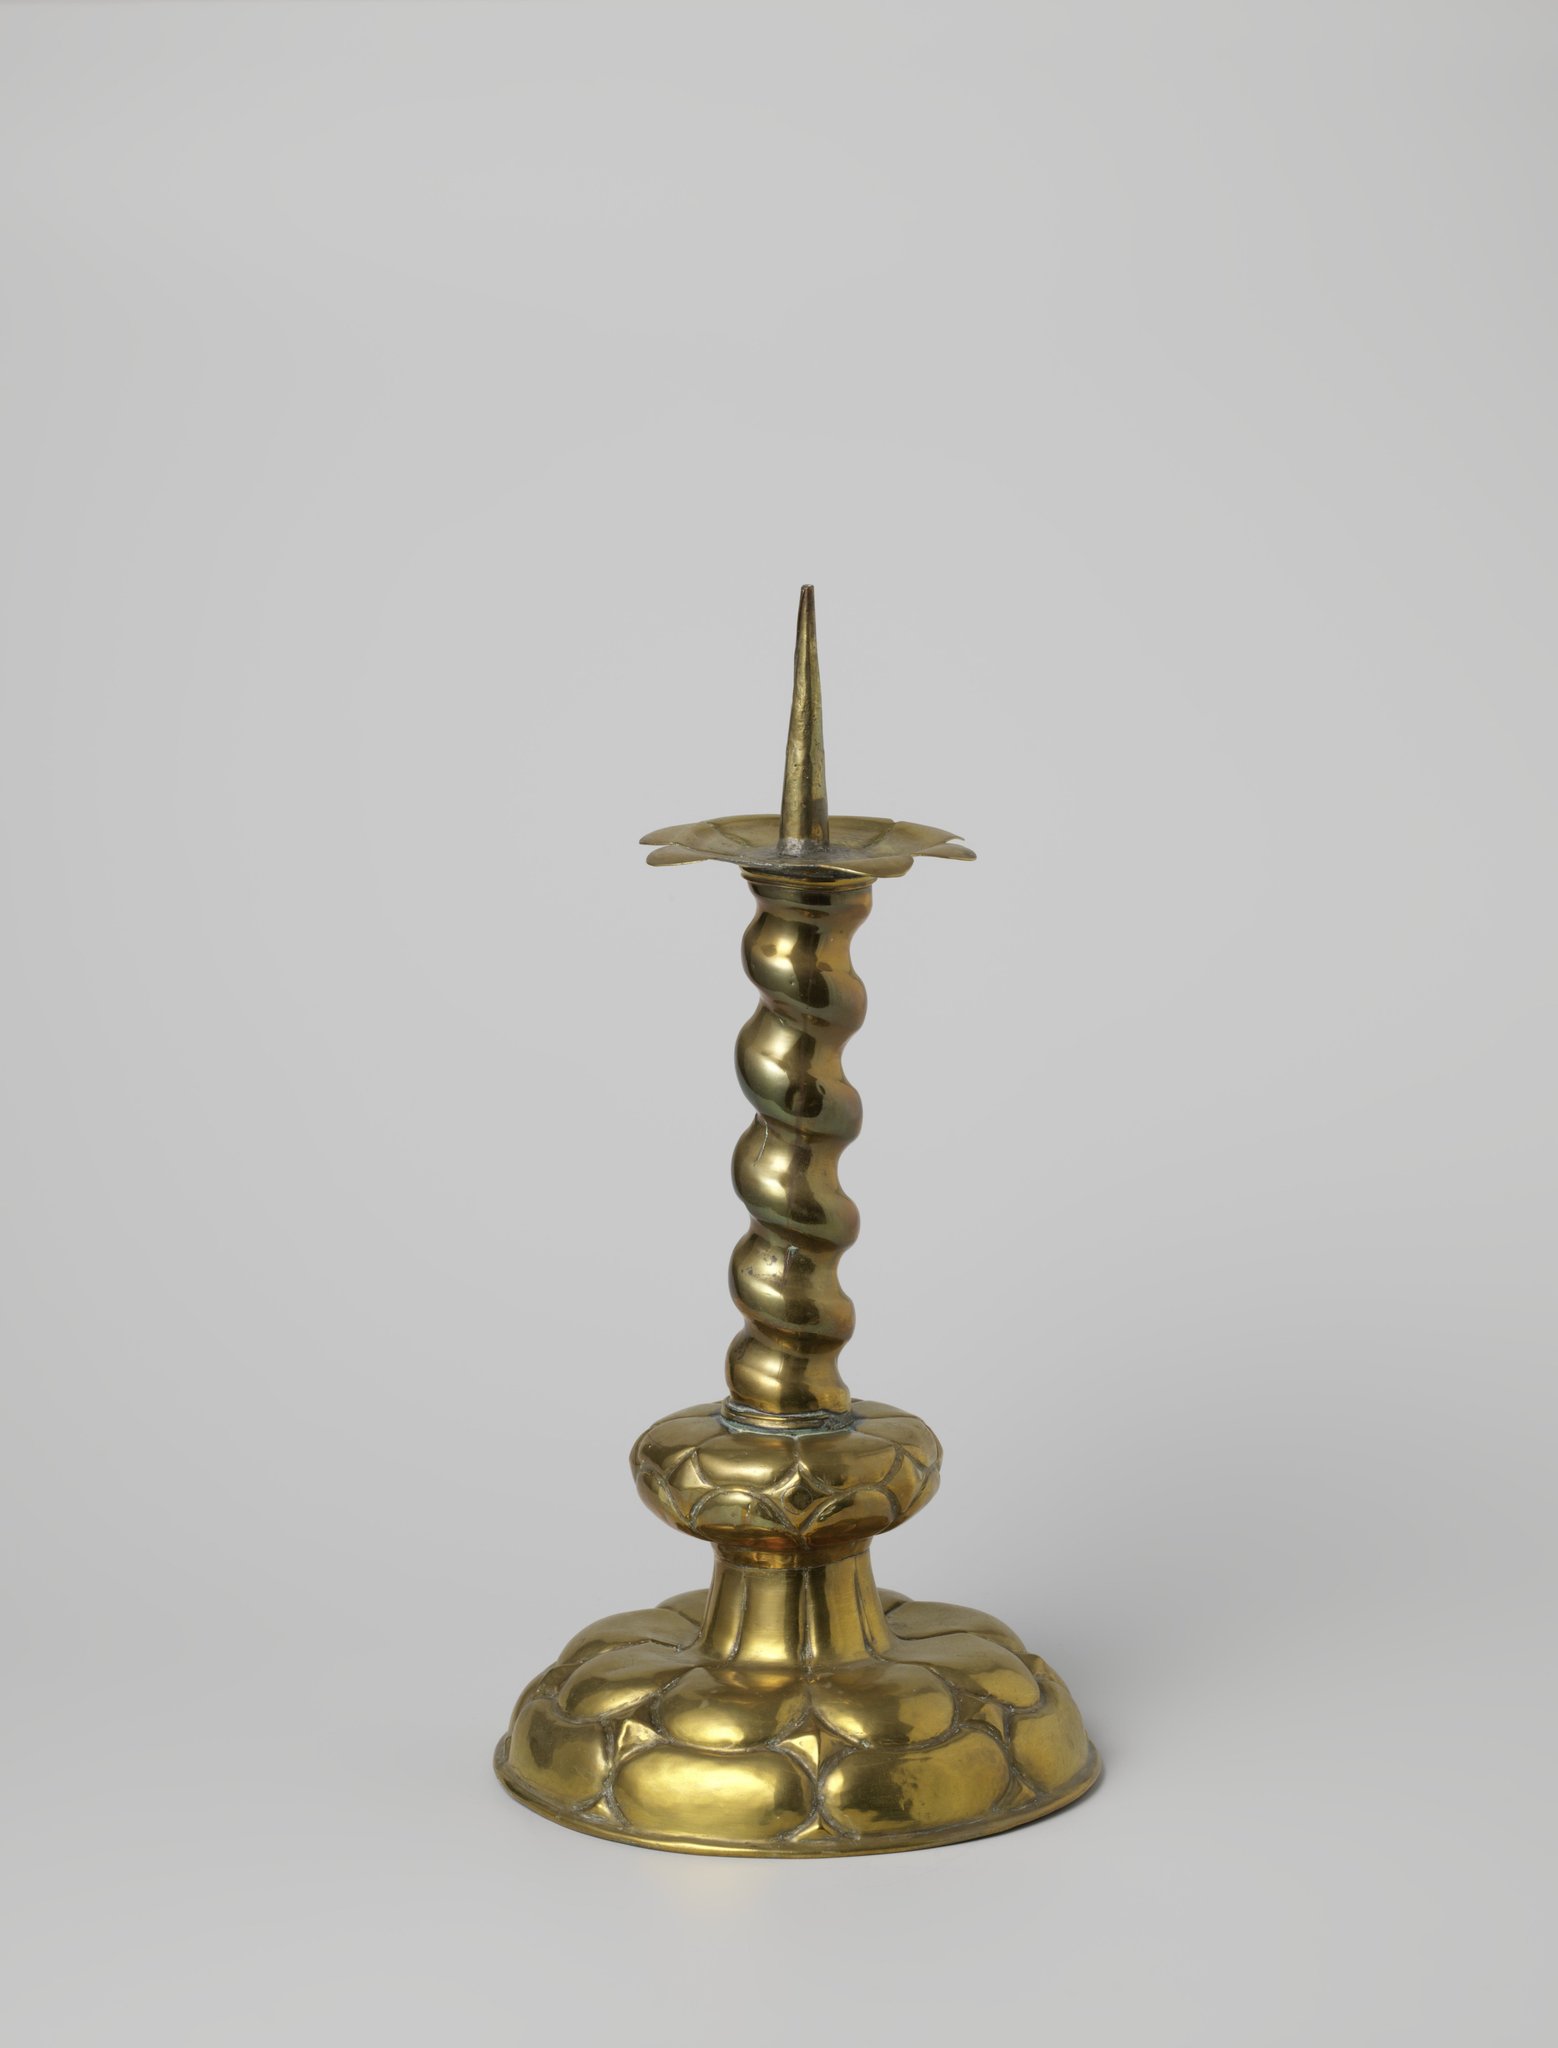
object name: candlestick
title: Kandelaar met getordeerde stam en achtlobbige voet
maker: Anonymous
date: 1625-1650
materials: brass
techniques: metalworking, screwed, soldering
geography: northern netherlands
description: De kandelaar is samengesteld uit de volgende uit plaat gedreven delen: de voet, de nodus, de stam, de vetvanger en de kaarsenpin. Om boven- en ondereind van de stam bevinden zich twee geprofileerde ringen. Op de brede, gewelfde, met acht lobben versierde voet is de vrij platte nodus geplaatst, waarvan de decoratie overeenkomt met die van de voet. De stam is getordeerd. De vetvanger heeft de vorm van een achtbladige rozet. De kandelaar heeft een gat aan de rand van de voet en daarboven een opening in de nodus. Stam en vetvanger zijn gesoldeerd.